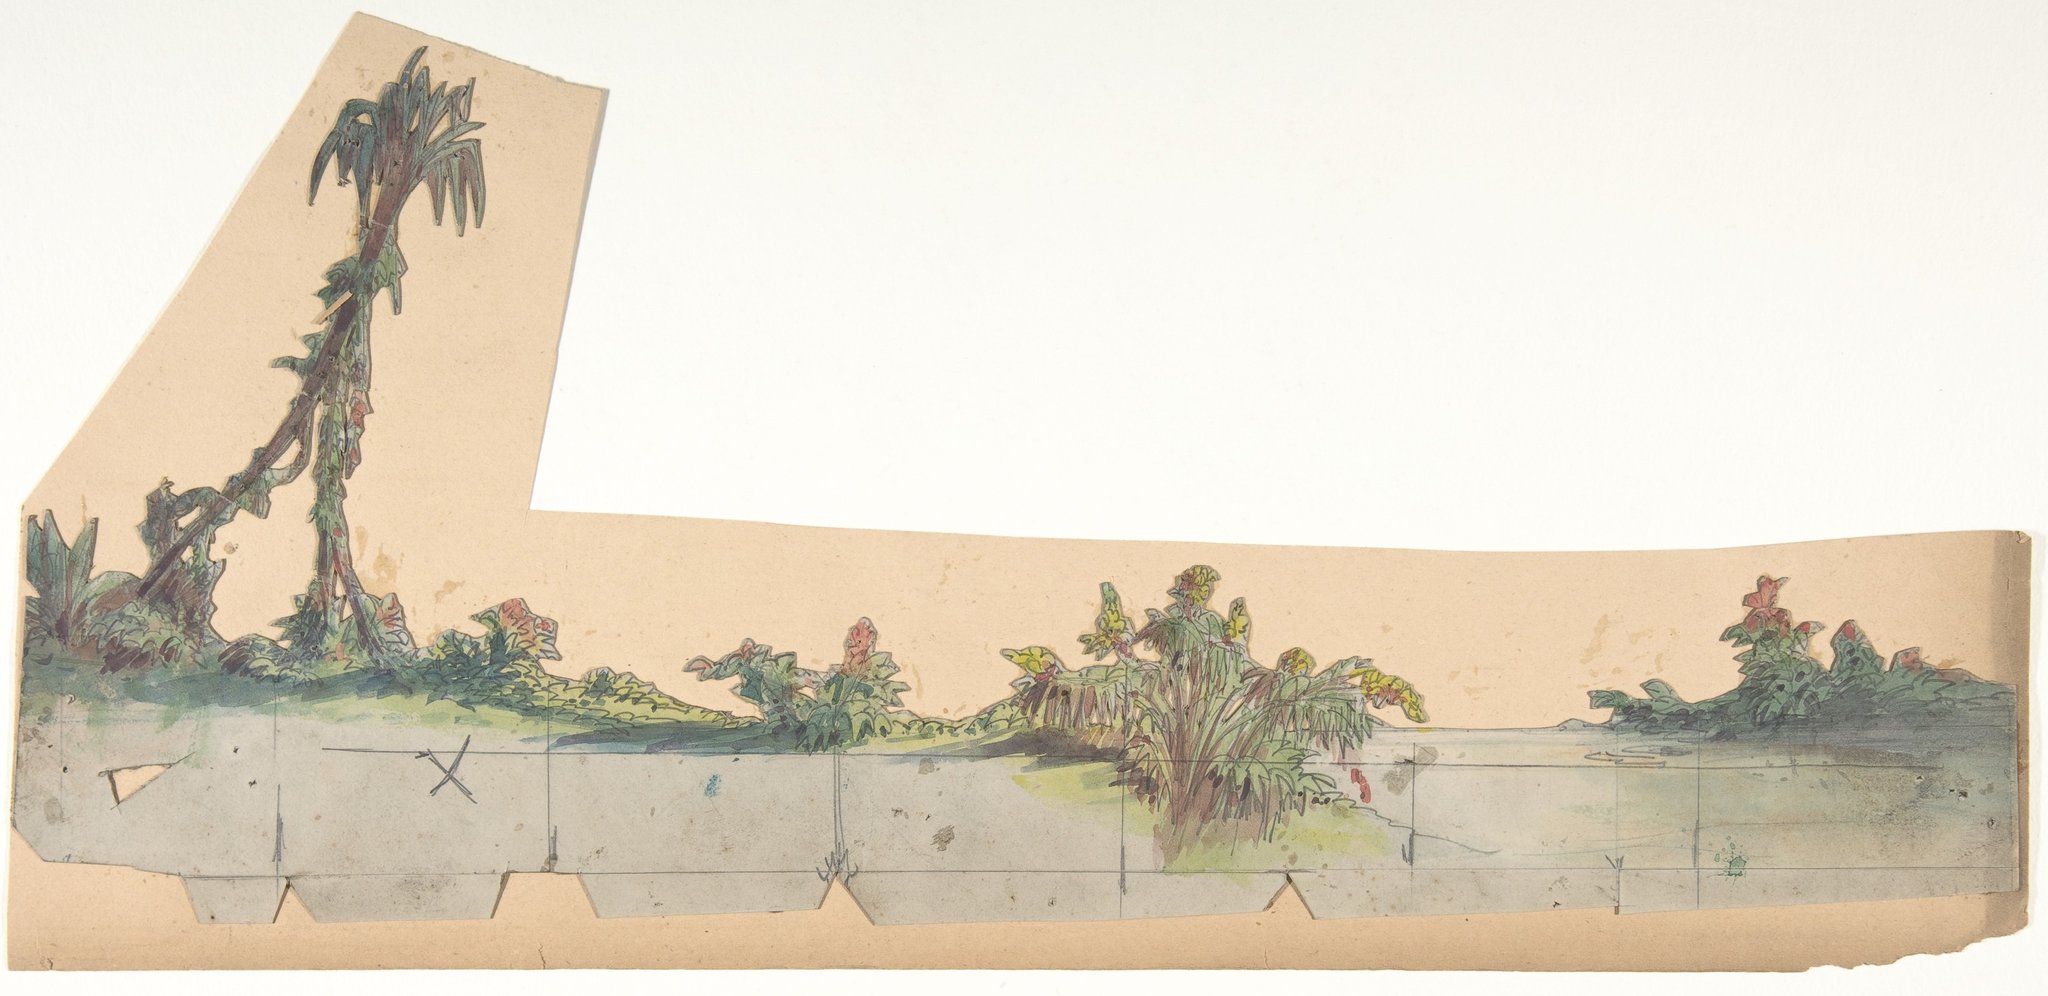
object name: drawing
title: Design for a Stage Set at the Opéra, Paris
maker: eugène cicéri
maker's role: artist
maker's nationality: french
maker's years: 1813-1890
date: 1828-1890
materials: graphite, watercolor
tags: trees,stage design